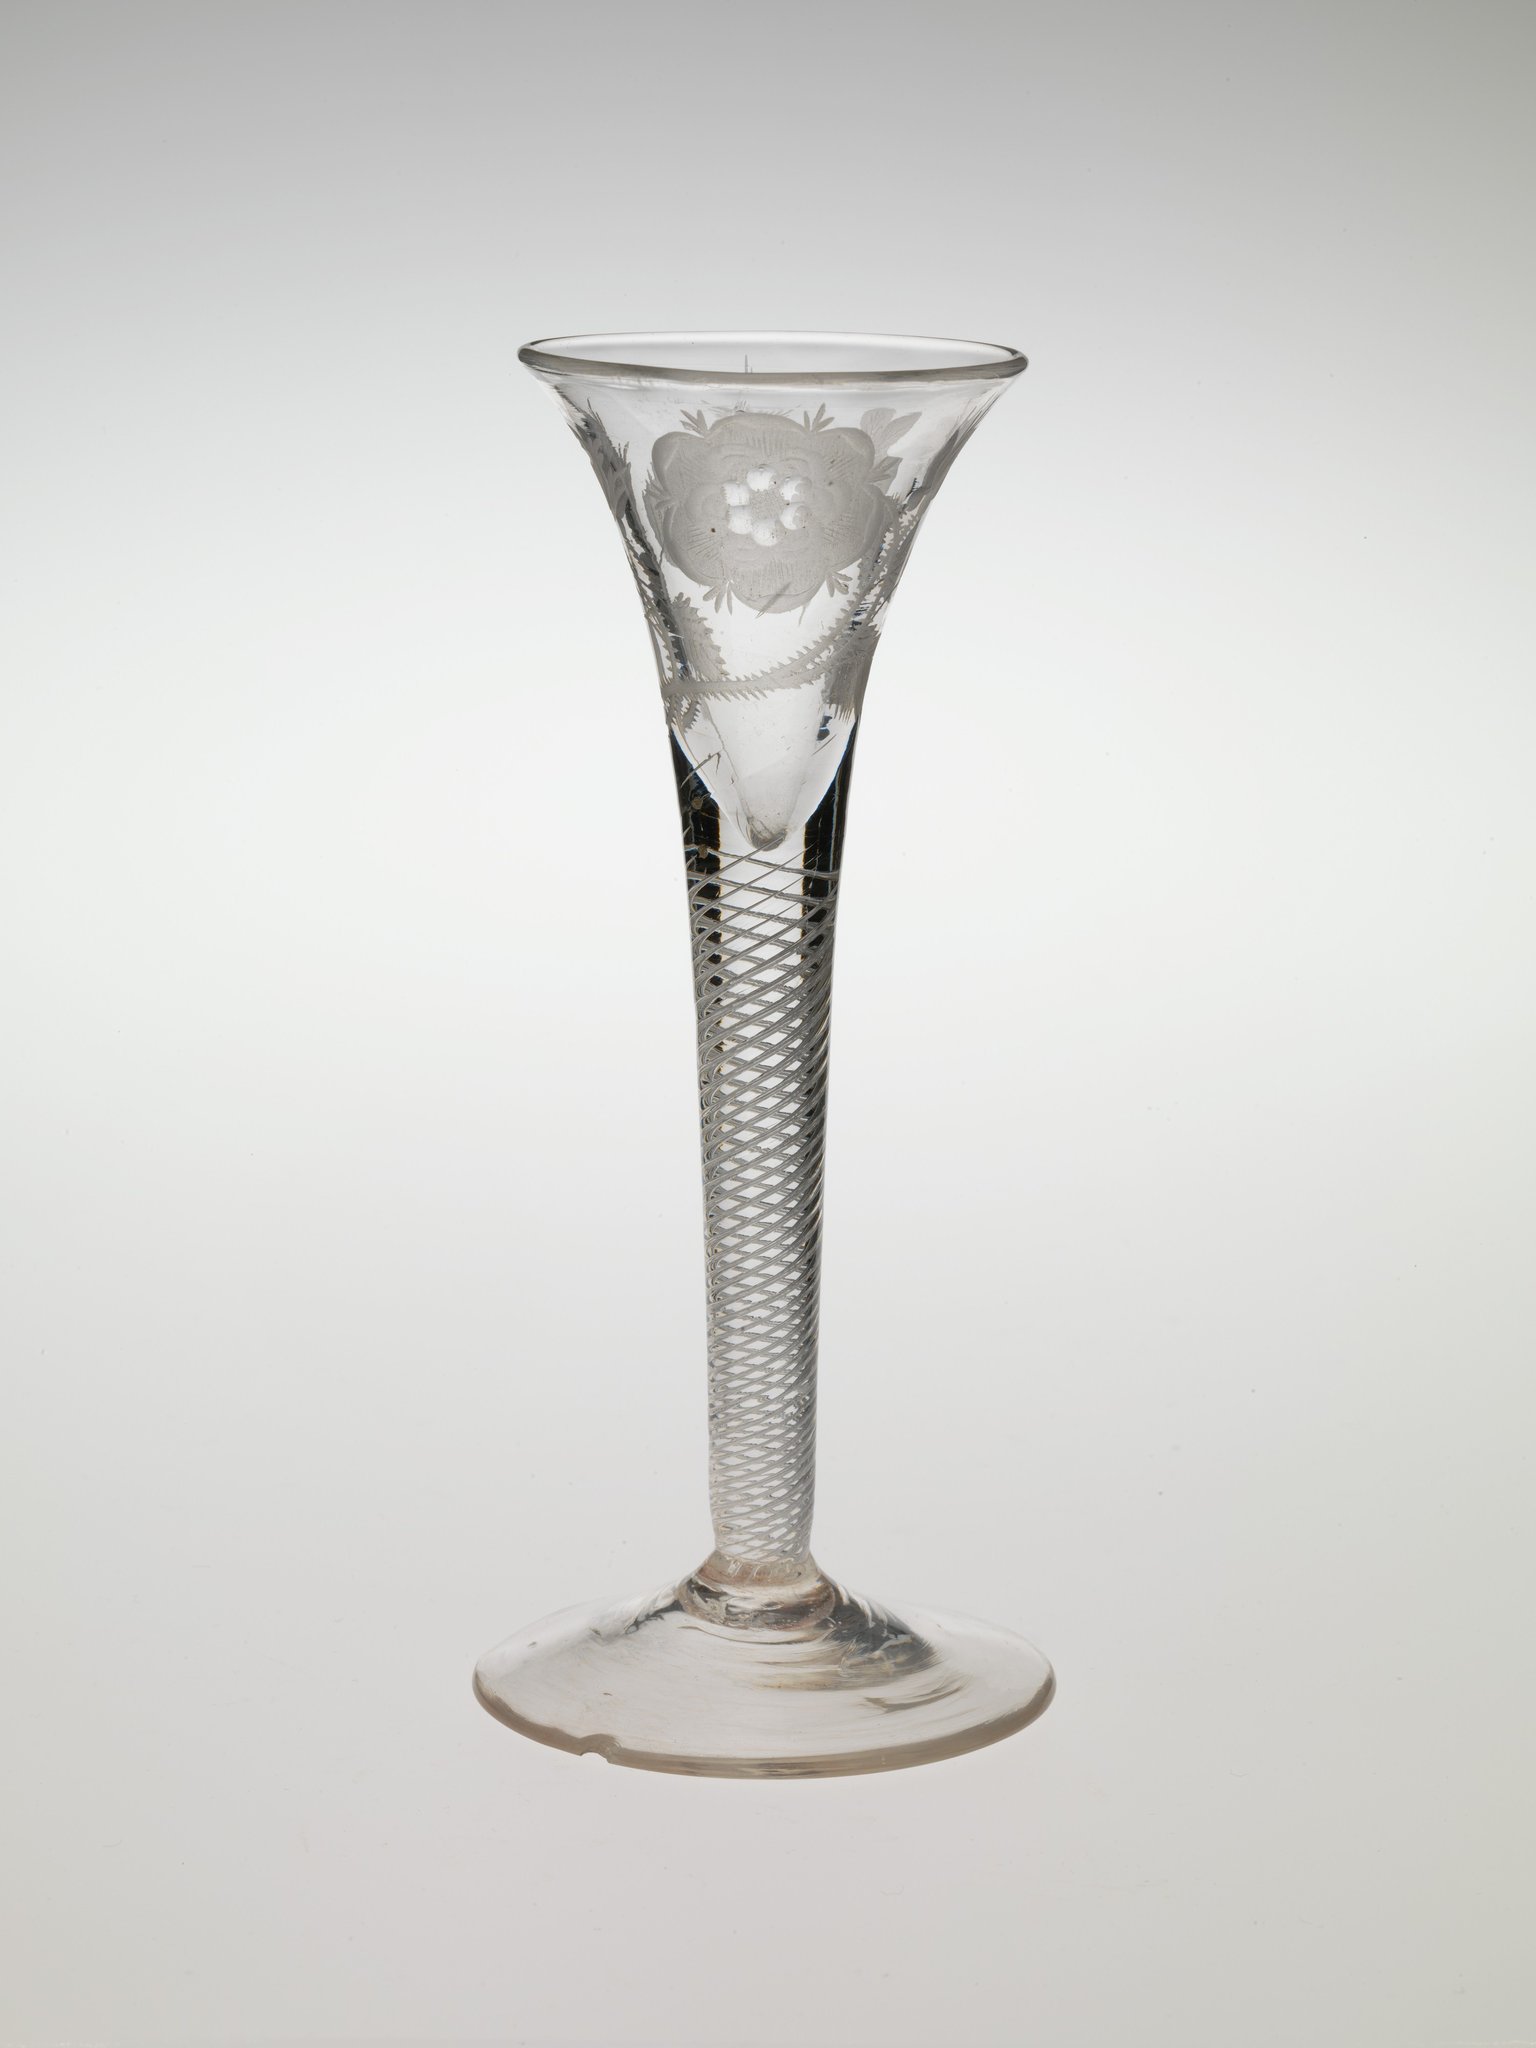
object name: wineglass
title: Wineglass with Jacobite emblems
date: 1745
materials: glass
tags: flowers